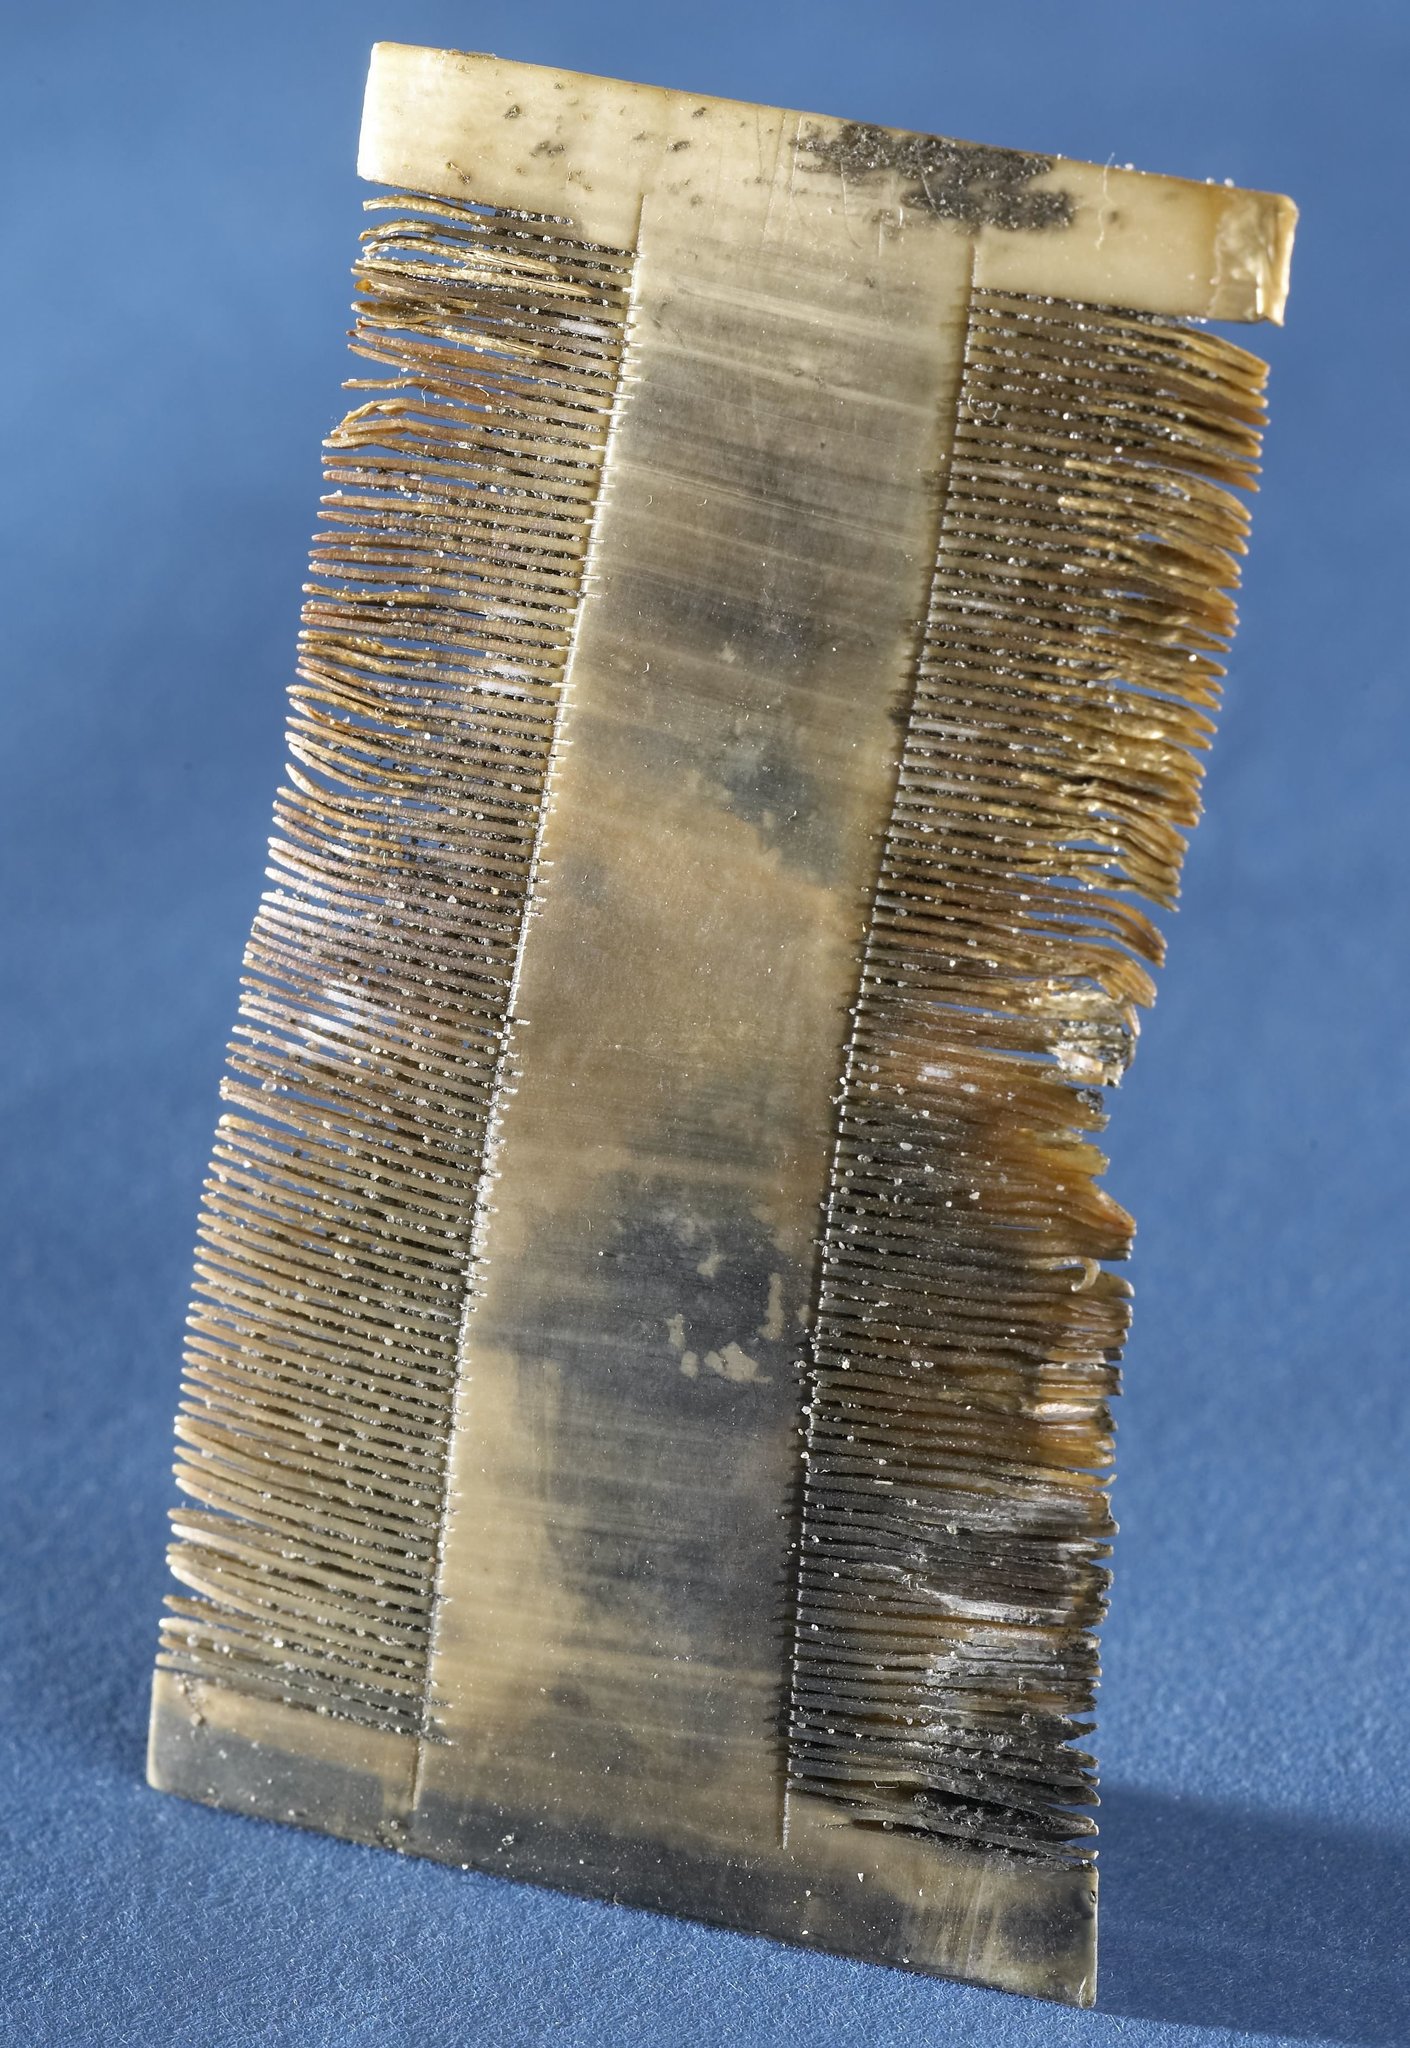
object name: louse comb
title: Luizenkam uit het wrak van de Oost-Indiëvaarder 't Vliegend Hart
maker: Anonymous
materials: bone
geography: middelburg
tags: 't vliegend hart (schip), verenigde oostindische compagnie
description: Benen kam, rechthoekig, tweezijdig met zeer fijne betanding. Gaaf maar modderig exemplaar. Lice comb.